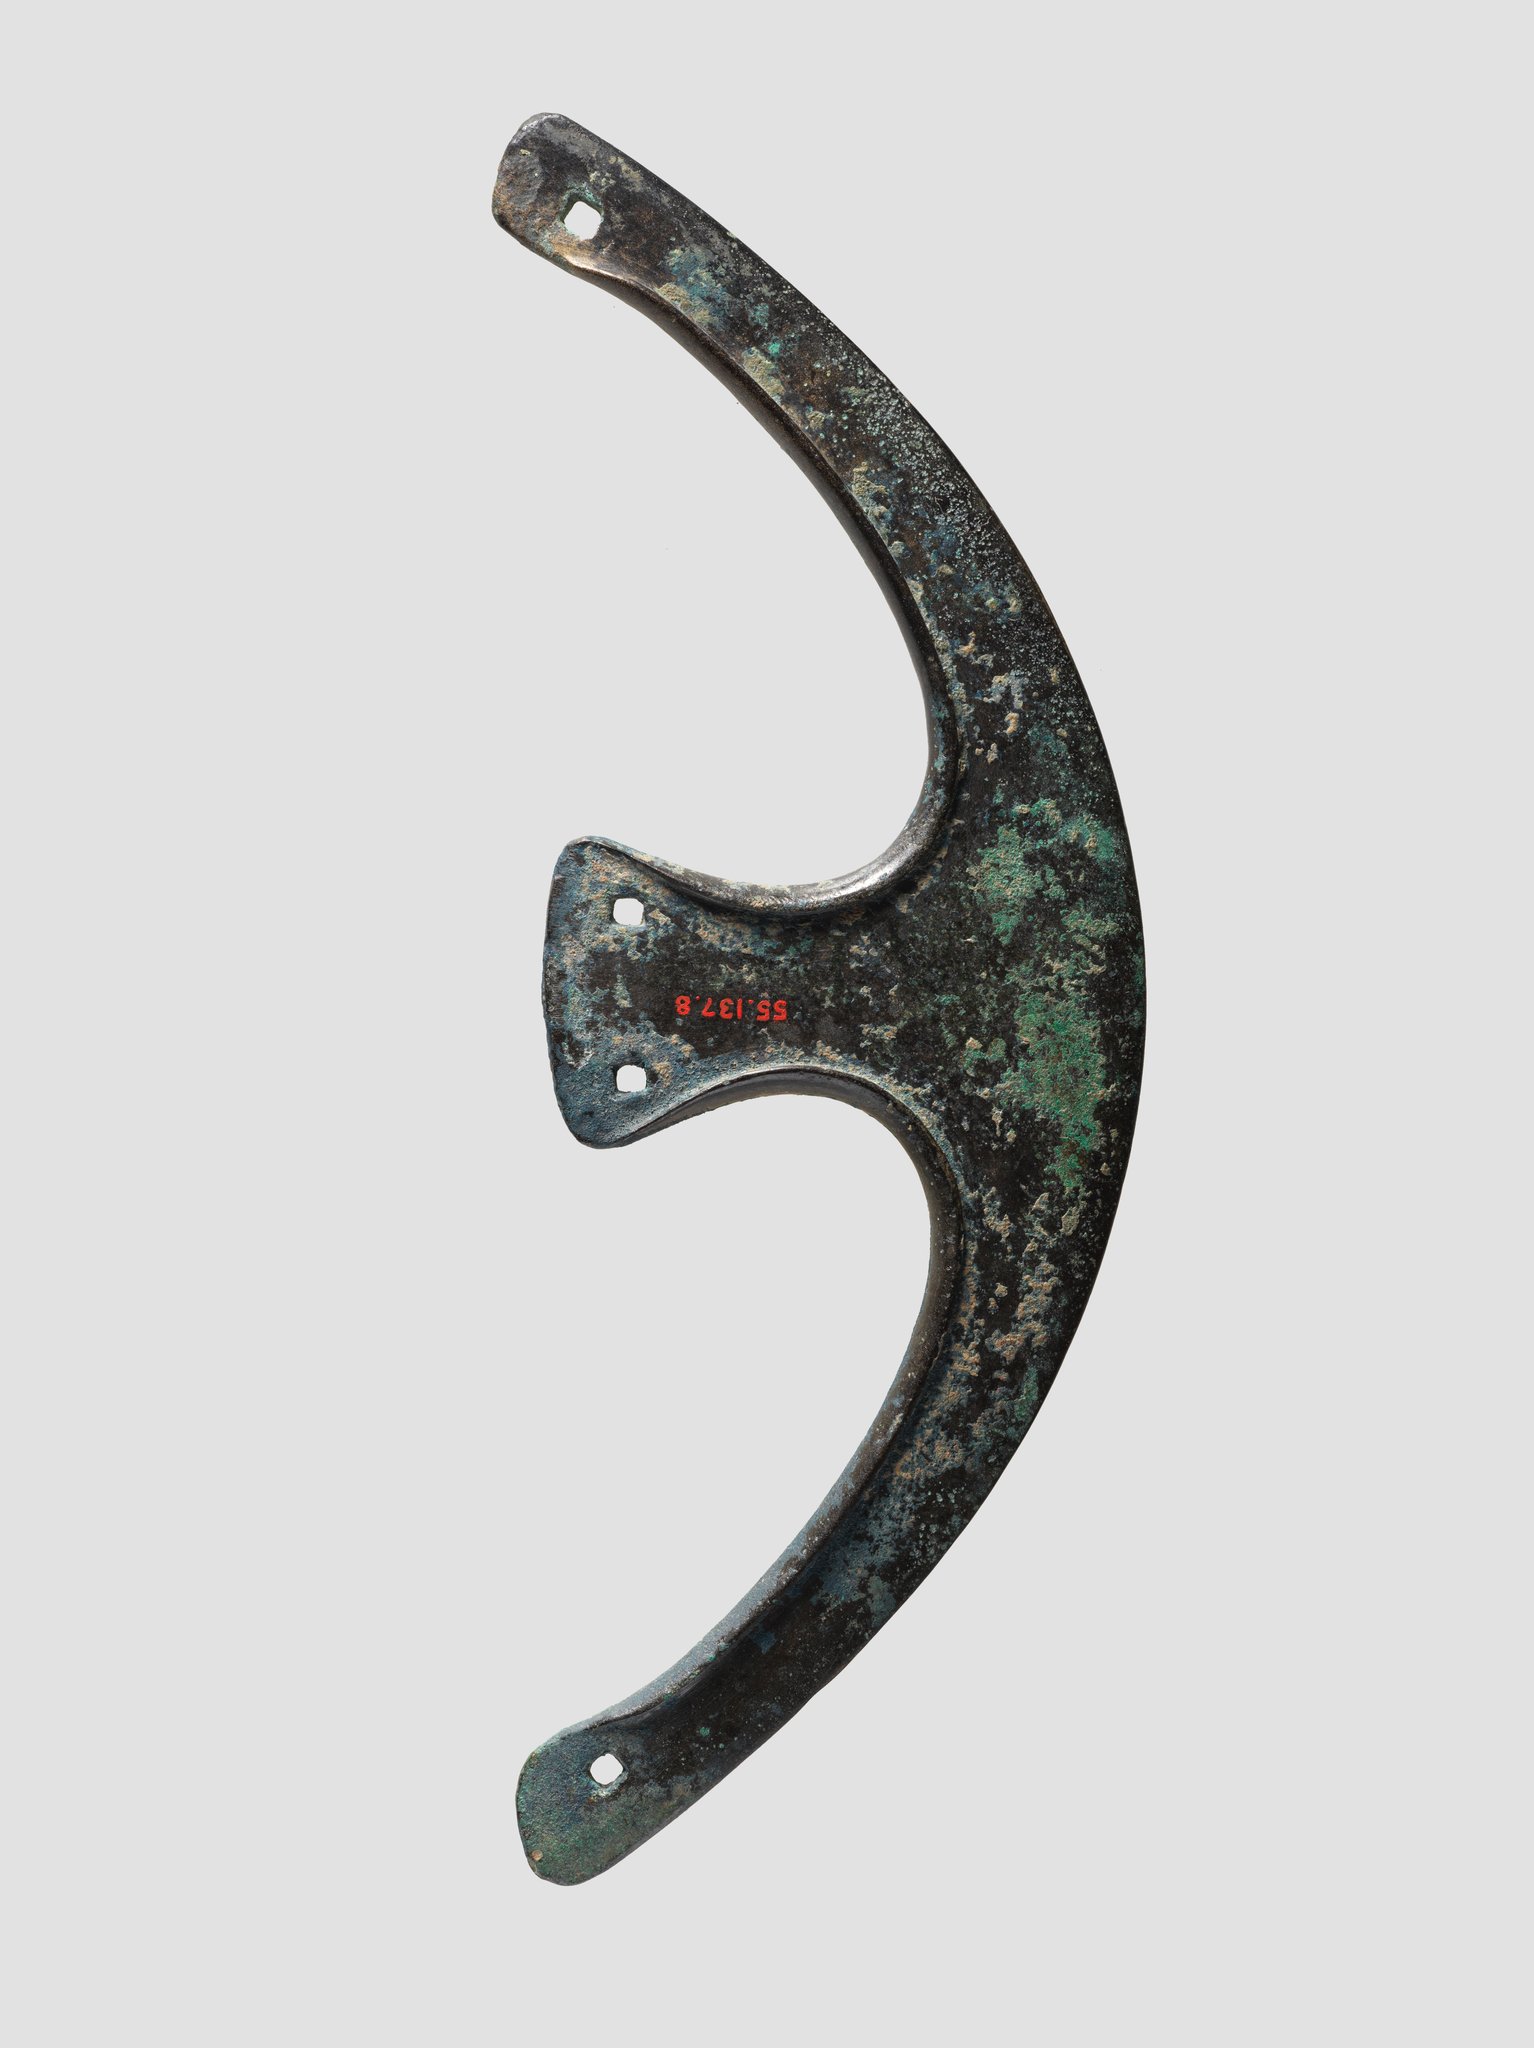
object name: axe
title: Crescent-shaped axe head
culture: hattian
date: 2300-2000 BCE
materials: bronze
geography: central anatolia